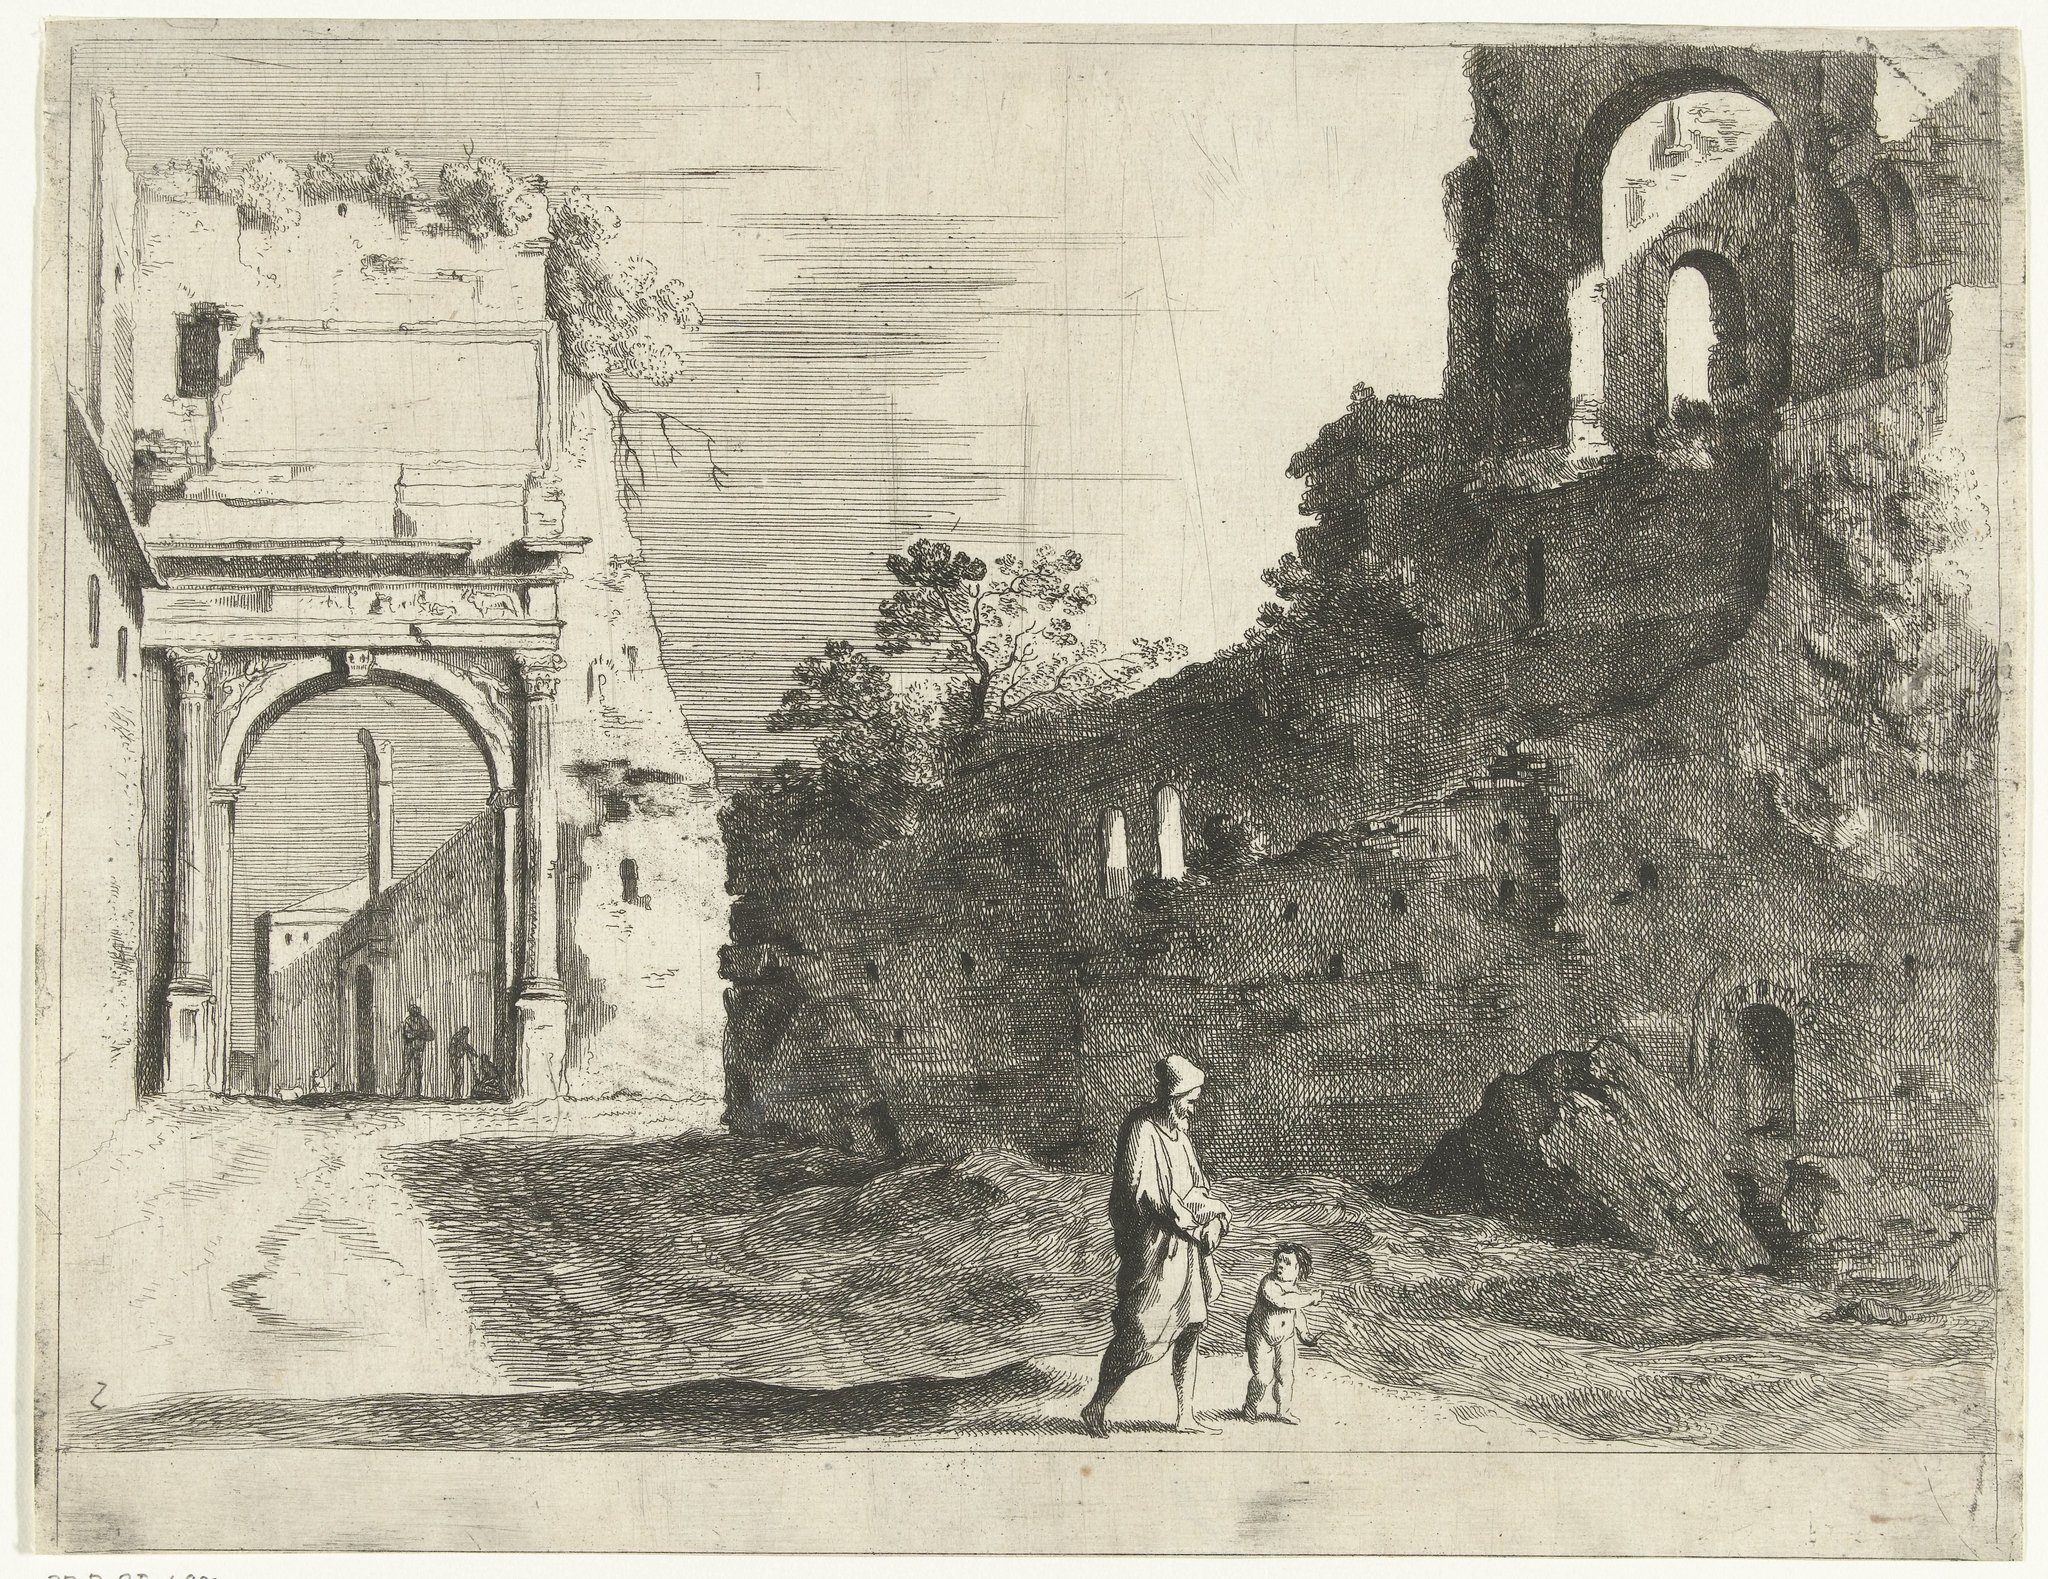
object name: print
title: Ruïne van Titusboog op Forum Romanum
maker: jan gerritsz. van bronckhorst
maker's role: draughtsman, painter, print maker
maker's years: 1603-1661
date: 1613-1661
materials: paper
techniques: etching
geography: netherlands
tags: ruin of a building ~ architecture, landscape with ruins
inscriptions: collector's mark: Lugt 240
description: Prent naar tekening van Cornelis van Poelenburch welke zich bevindt in de collectie van de Kunsthalle te Hamburg. Prent uit serie van negen prenten met Romeinse ruïnes.